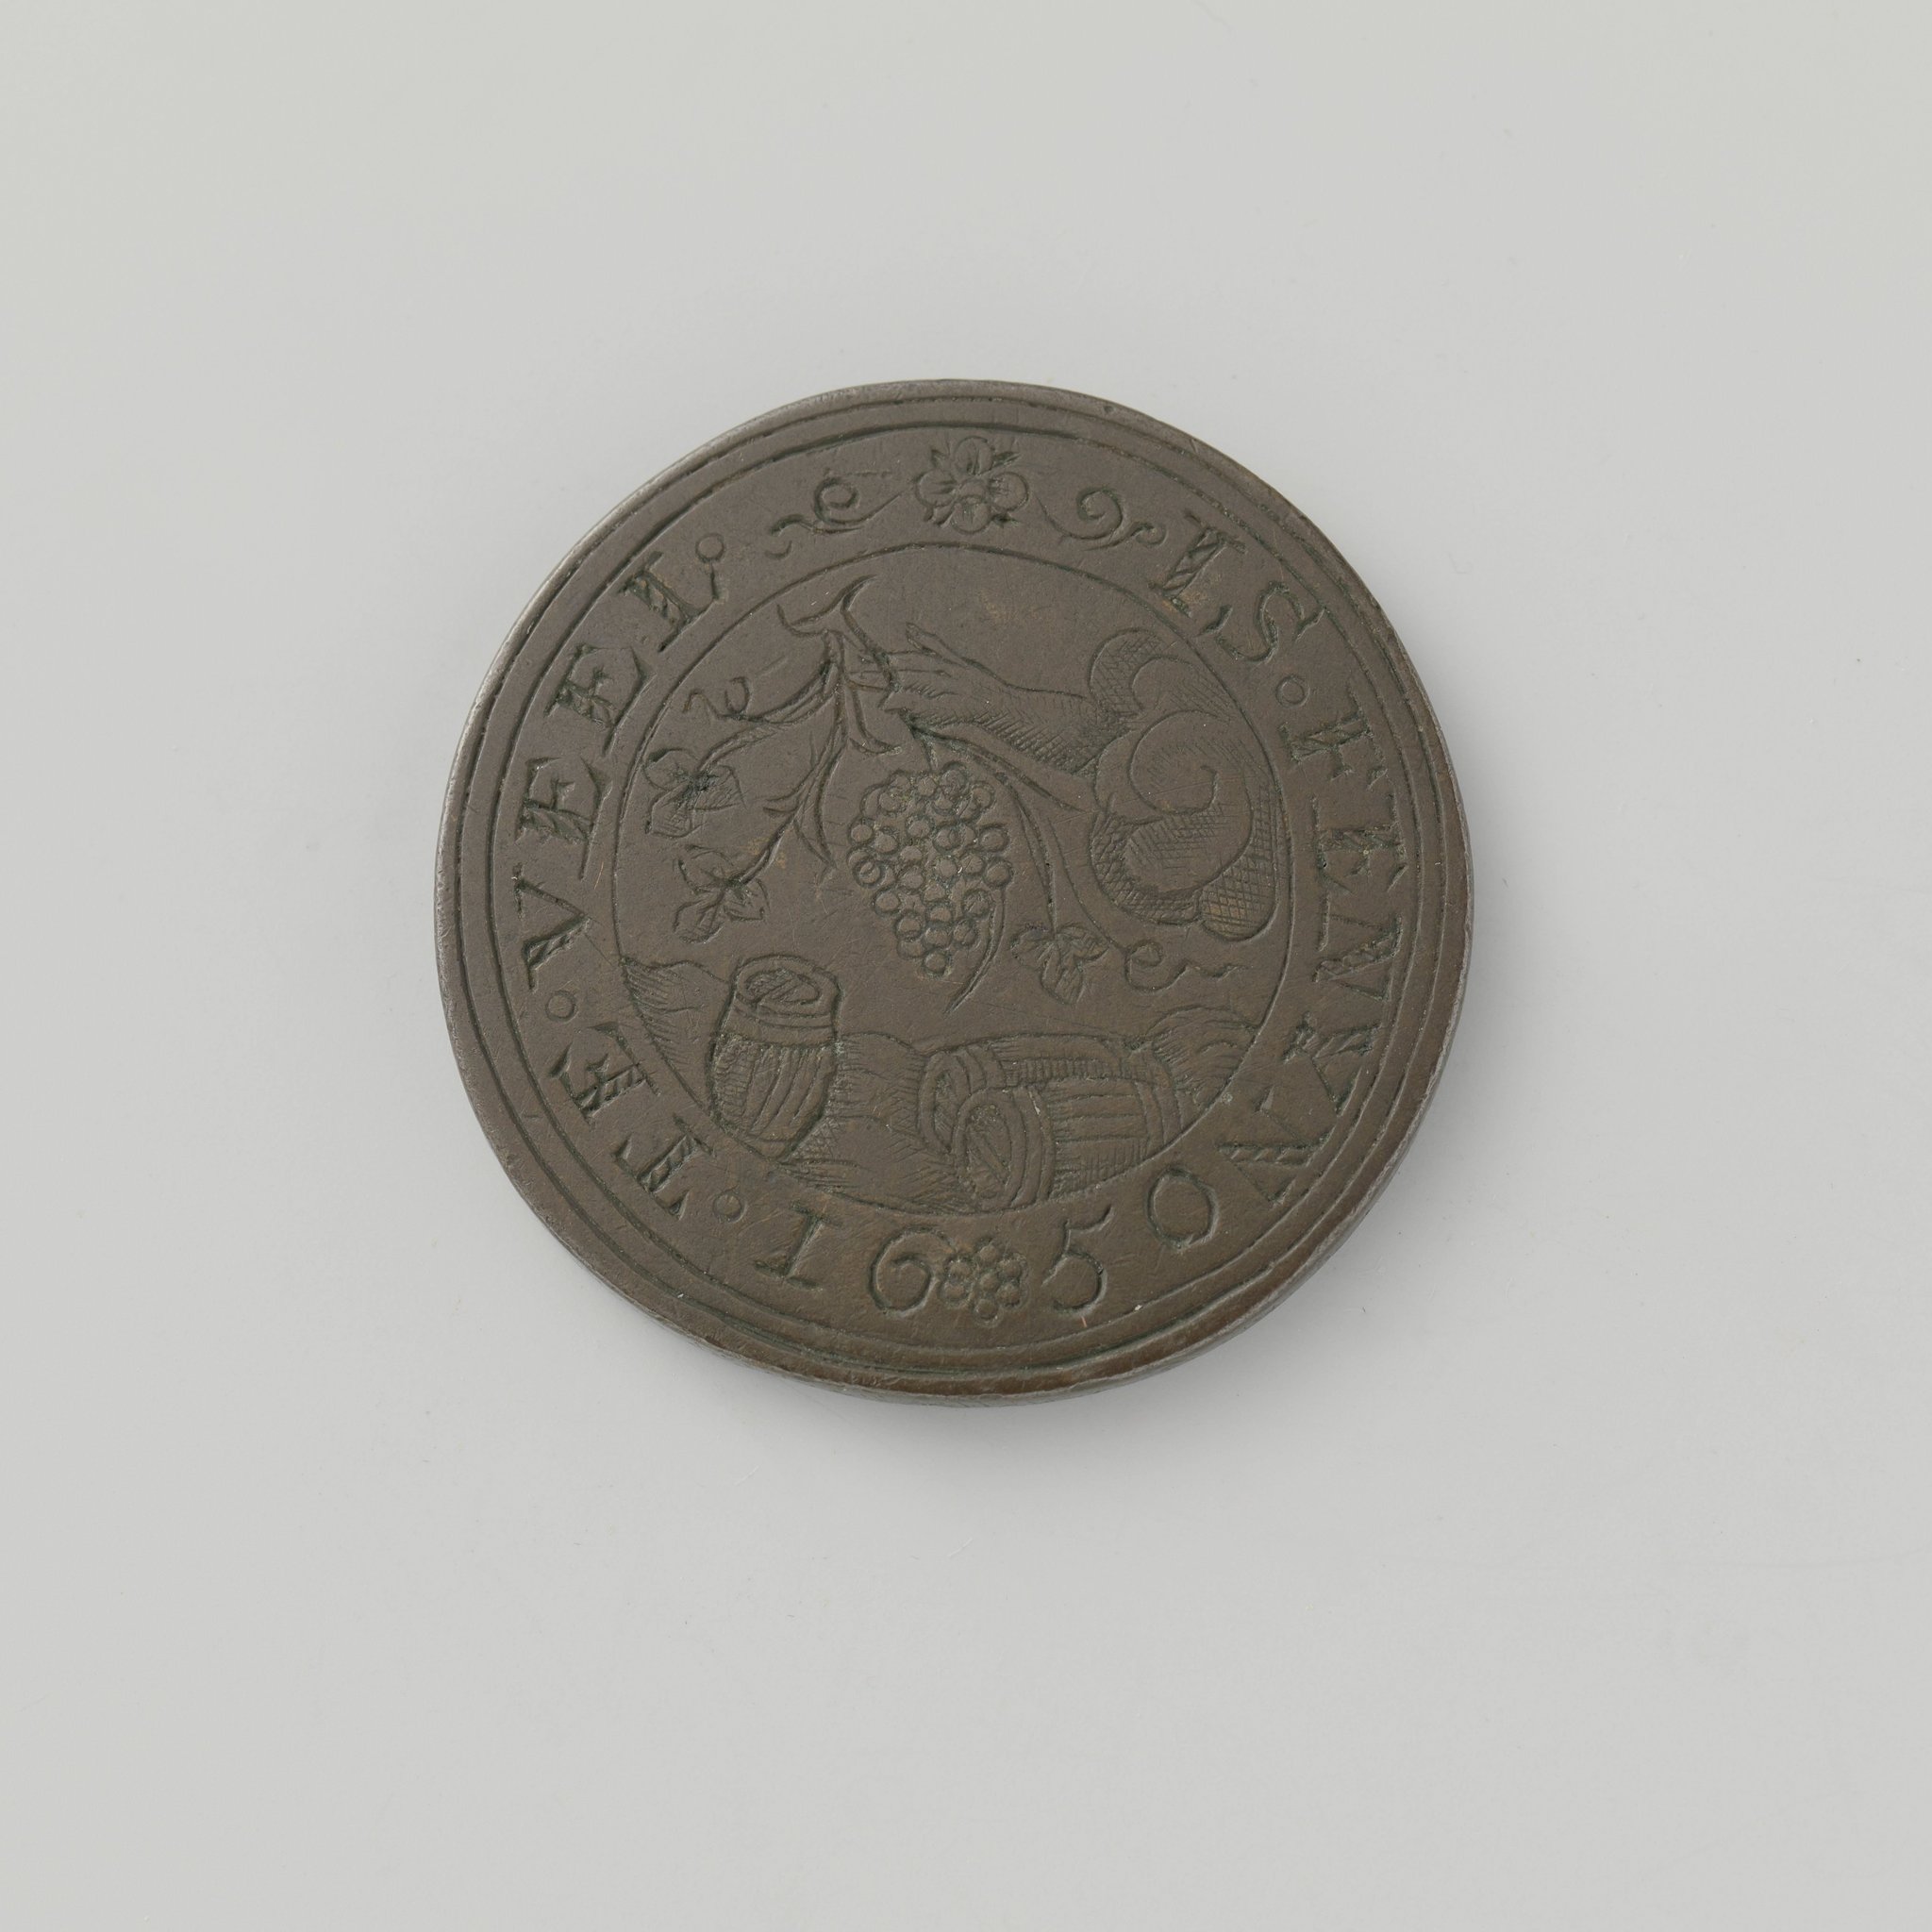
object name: medal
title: Wine Merchants, Utrecht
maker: Anonymous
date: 1741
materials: copper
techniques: engraving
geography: utrecht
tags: utrecht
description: Guild medals Members of trade guilds had to identify themselves with a medal at their meetings.